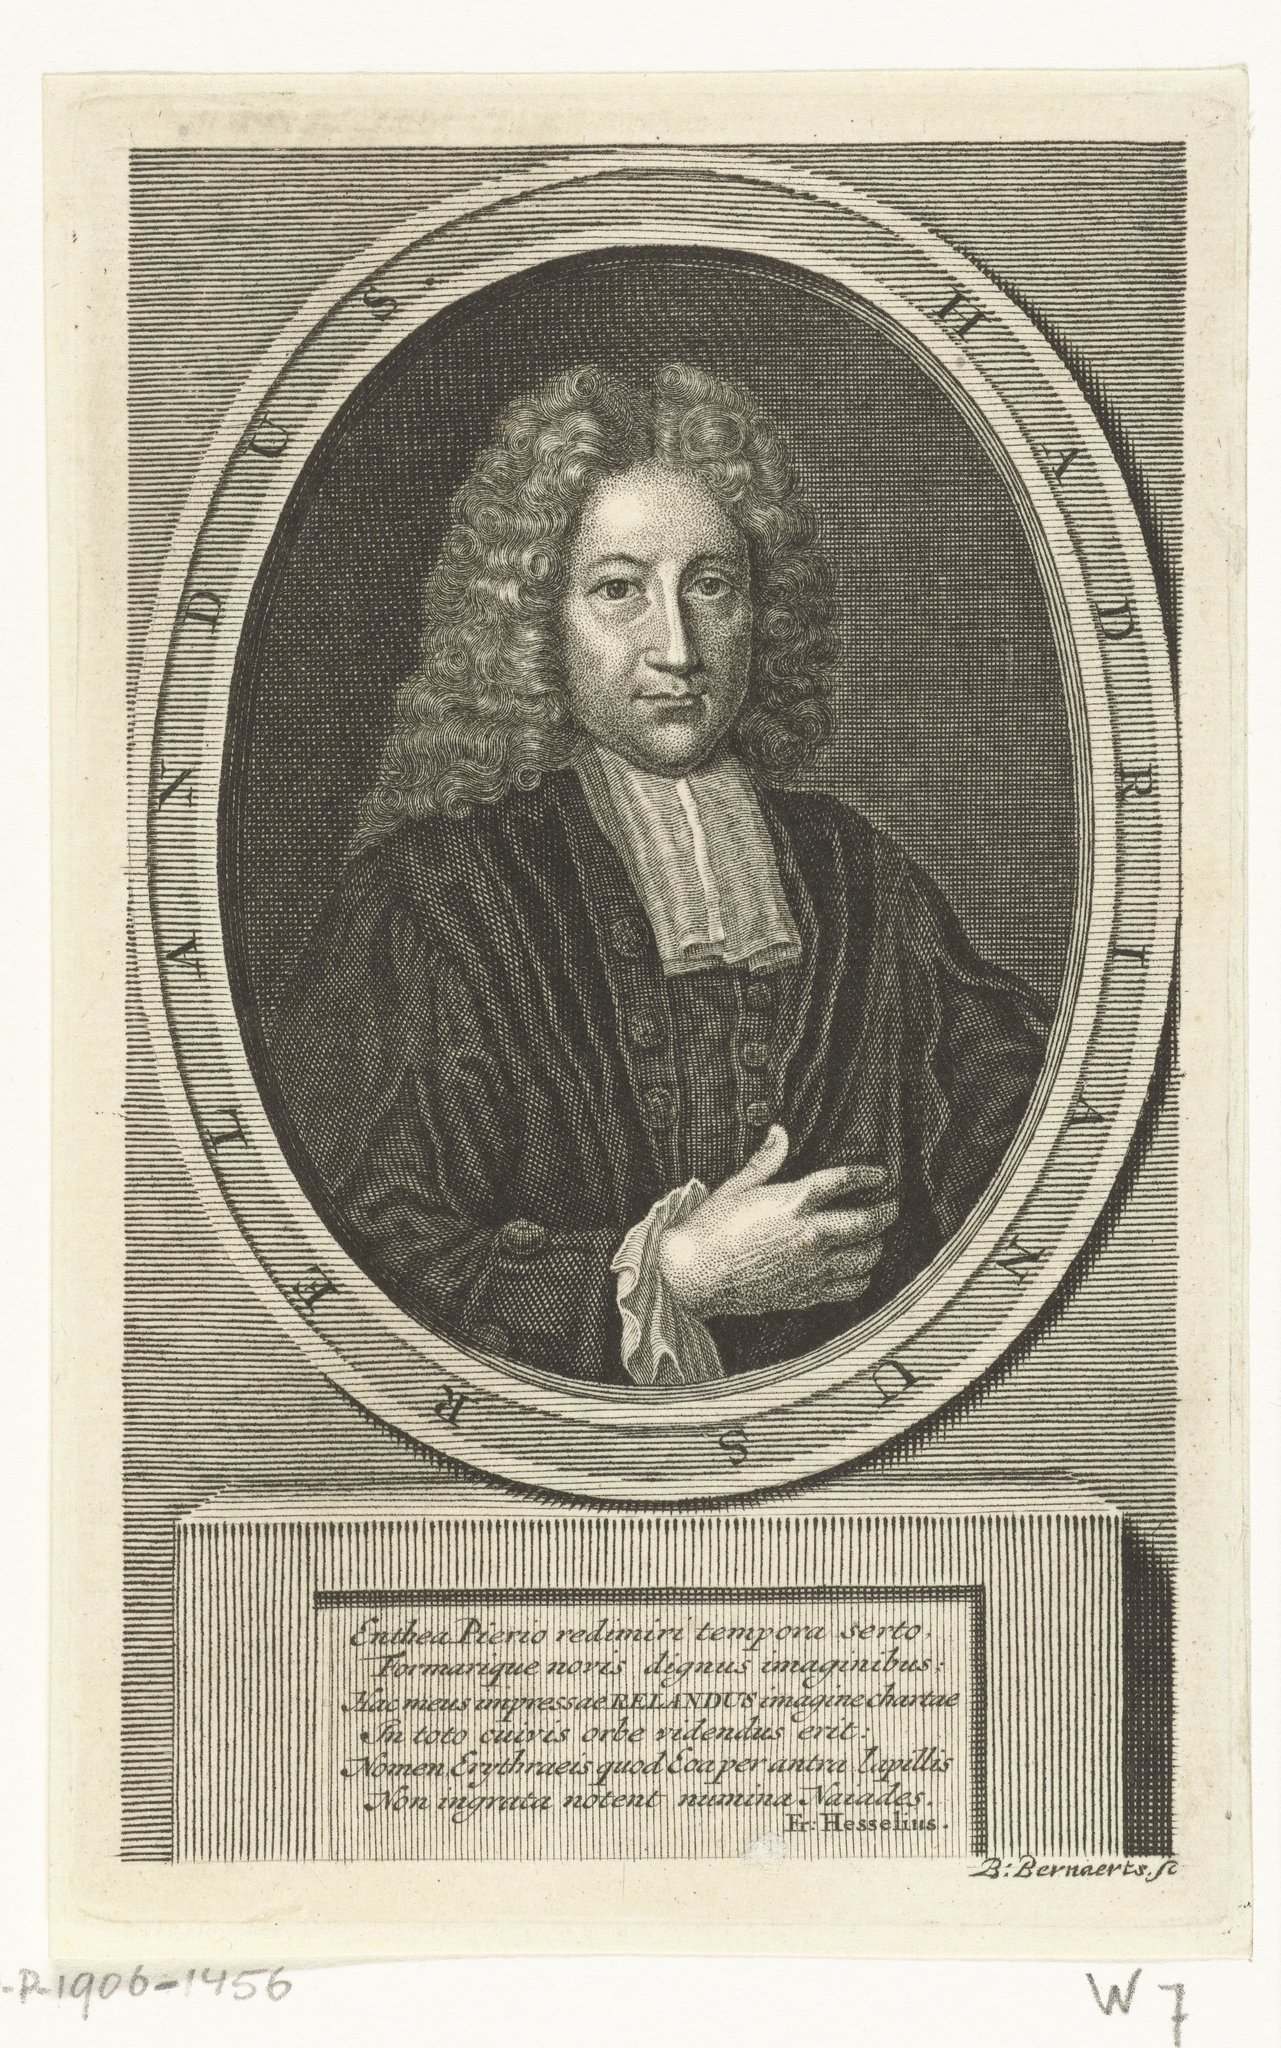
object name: print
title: Portret van Adriaan Reland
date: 1711-1737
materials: paper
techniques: engraving, etching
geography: amsterdam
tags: adriaan reeland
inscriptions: collector's mark: Lugt 2228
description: Borstbeeld van de Utrechtse hoogleraar Adriaan Reland met toga en pruik. Onder het portret een vers in het Latijn door F. Hesselius.